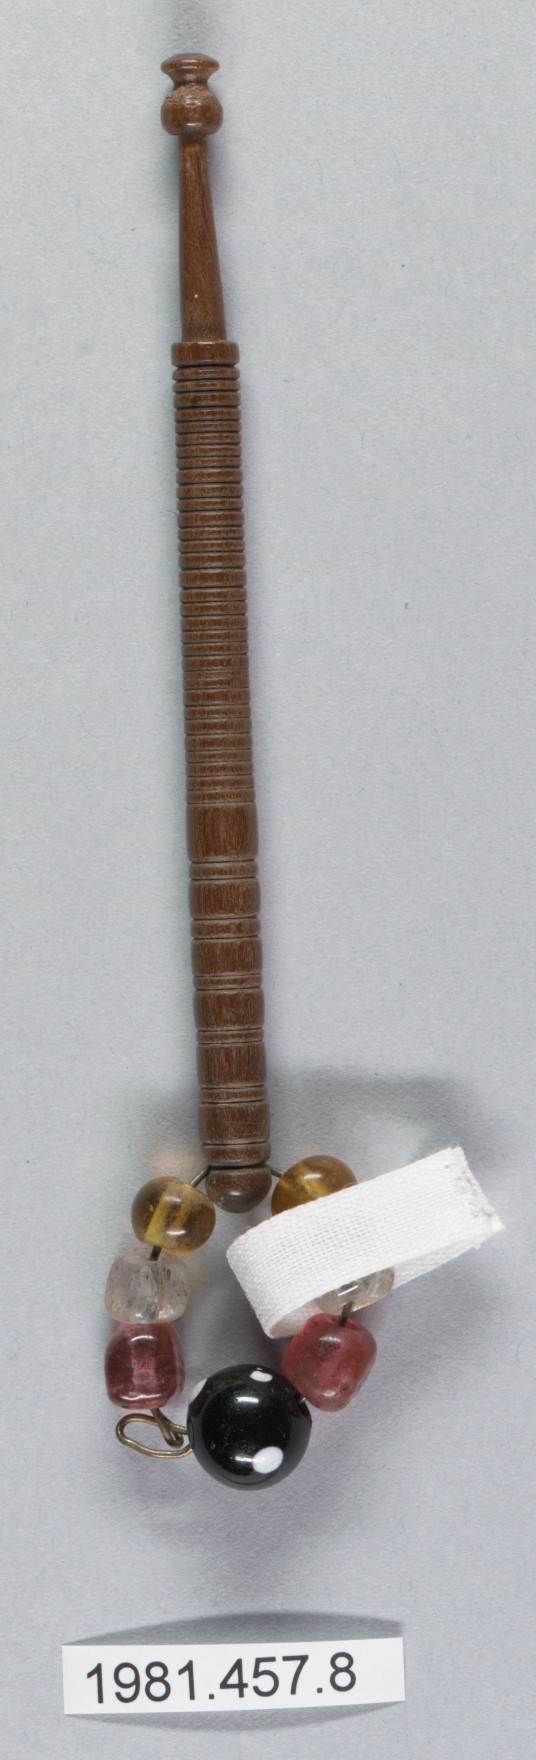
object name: bobbin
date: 1840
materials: wood